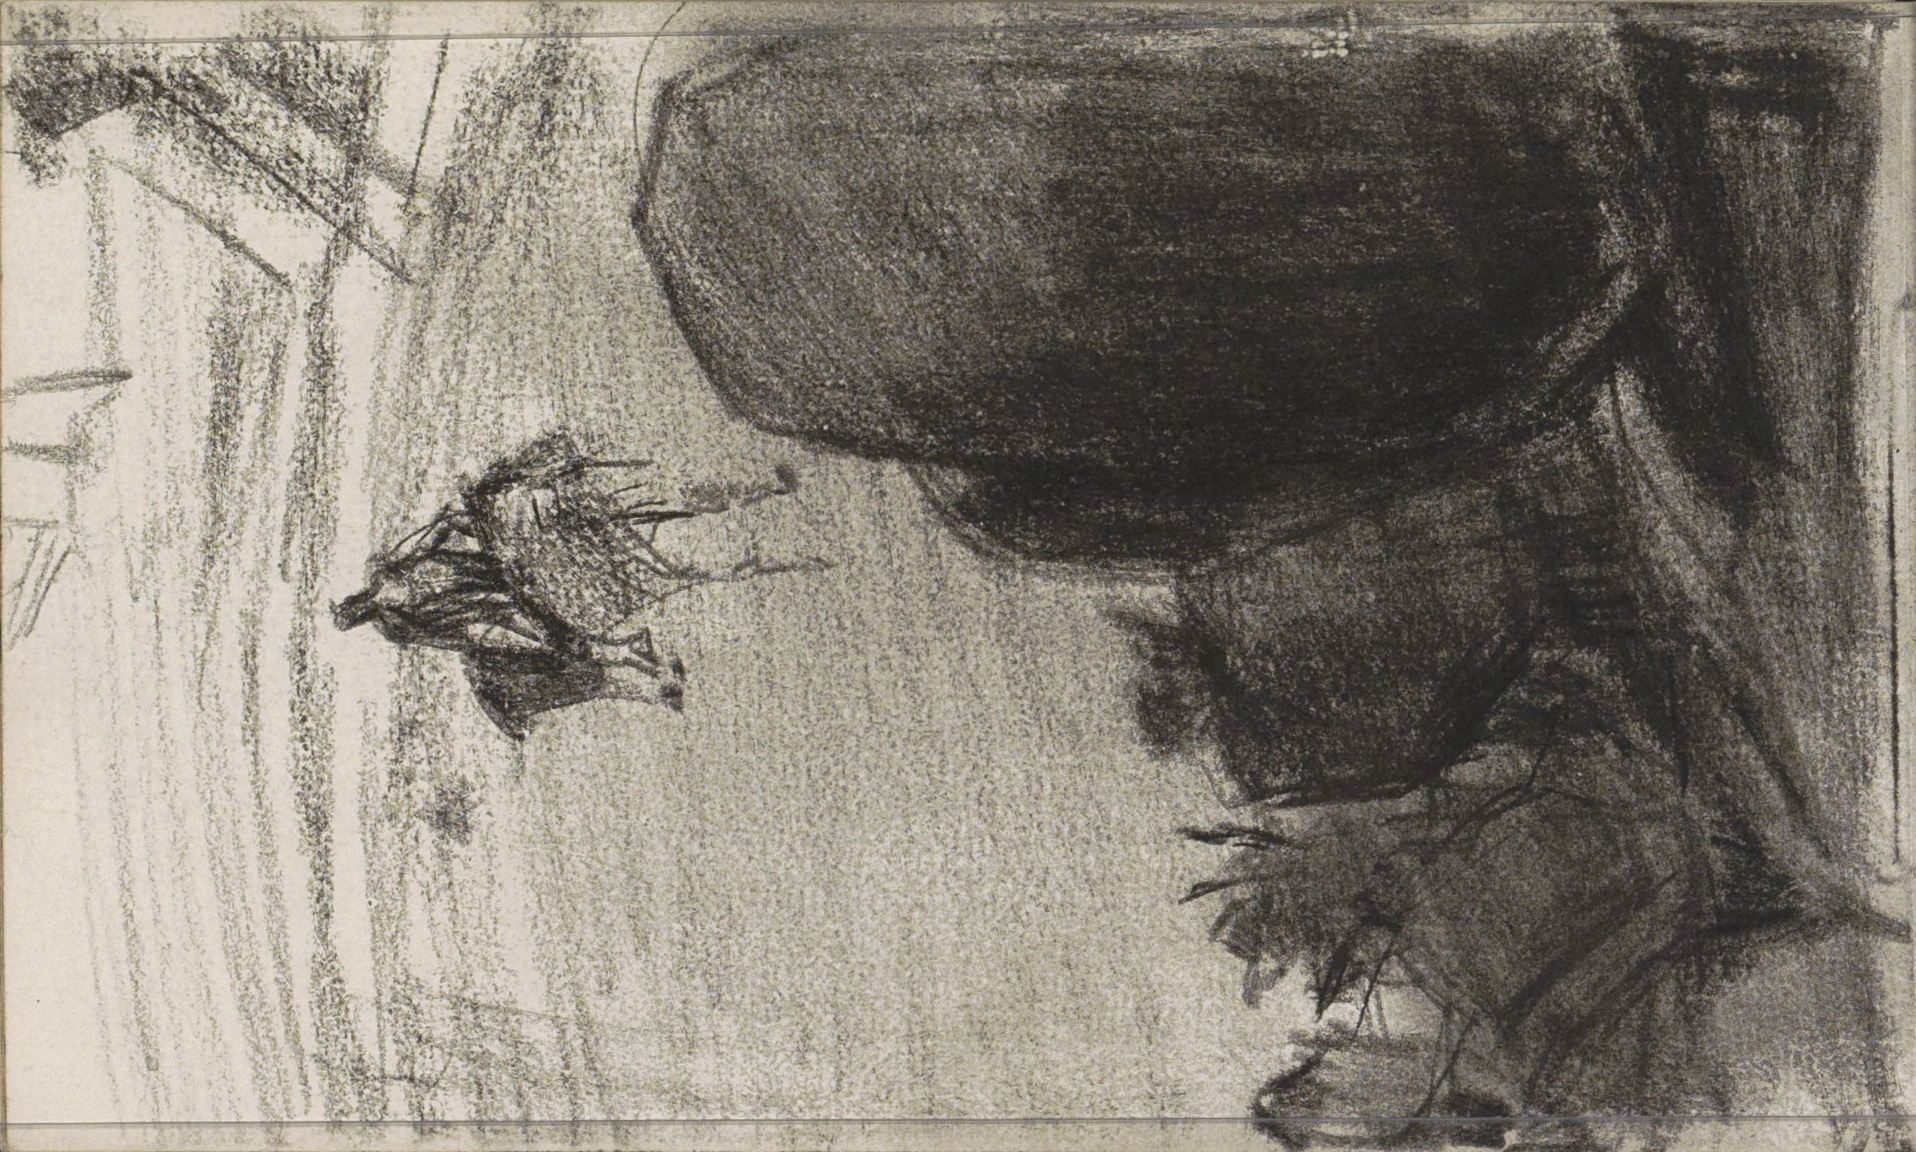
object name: sketchbook leaf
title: Toeschouwers bij een voorstelling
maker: isaac israels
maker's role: draughtsman, painter, print maker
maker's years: 1865-1934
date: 1875-1934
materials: chalk, paper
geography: the hague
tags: riding a horse, ass, or mule; rider, horseman, the audience ~ art performance, the stage and its equipment, circus ring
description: Op het toneel of in de circuspiste een man te paard. Pagina 52 uit schetsboek XLVIII met 62 pagina's.